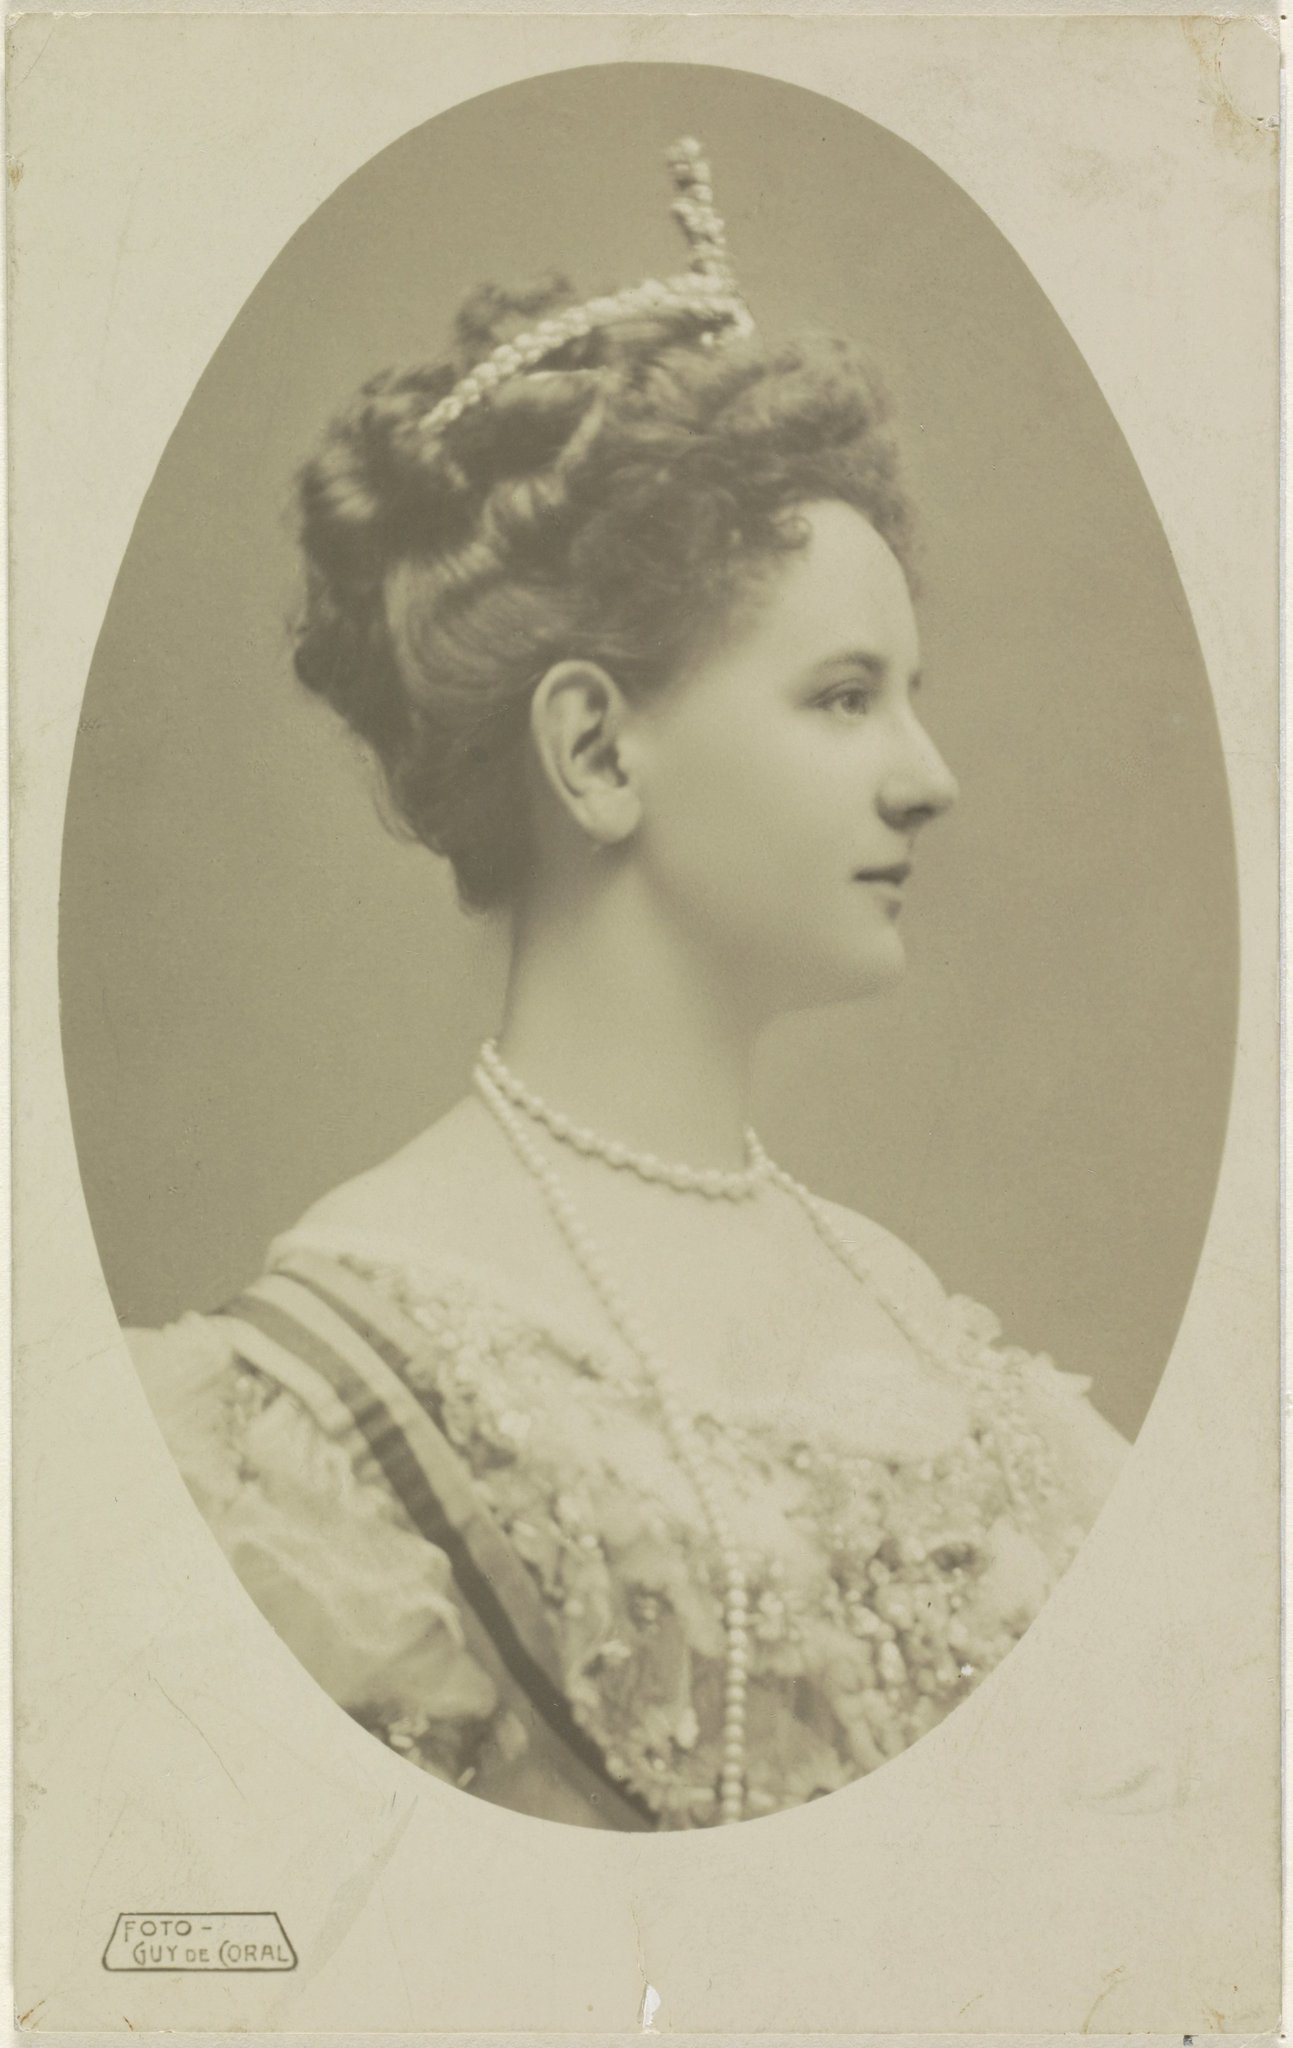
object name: ansichtkaart, prentbriefkaart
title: Portret van Wilhelmina, koningin der Nederlanden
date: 1905-1910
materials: photographic support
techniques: photography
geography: netherlands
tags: the hague, print maker, wilhelmina of the netherlands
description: De hier vermelde titel verwijst naar de hoogst verkregen titel van de geportretteerde, niet per se naar de titel die de geportretteerde op deze voorstelling draagt.